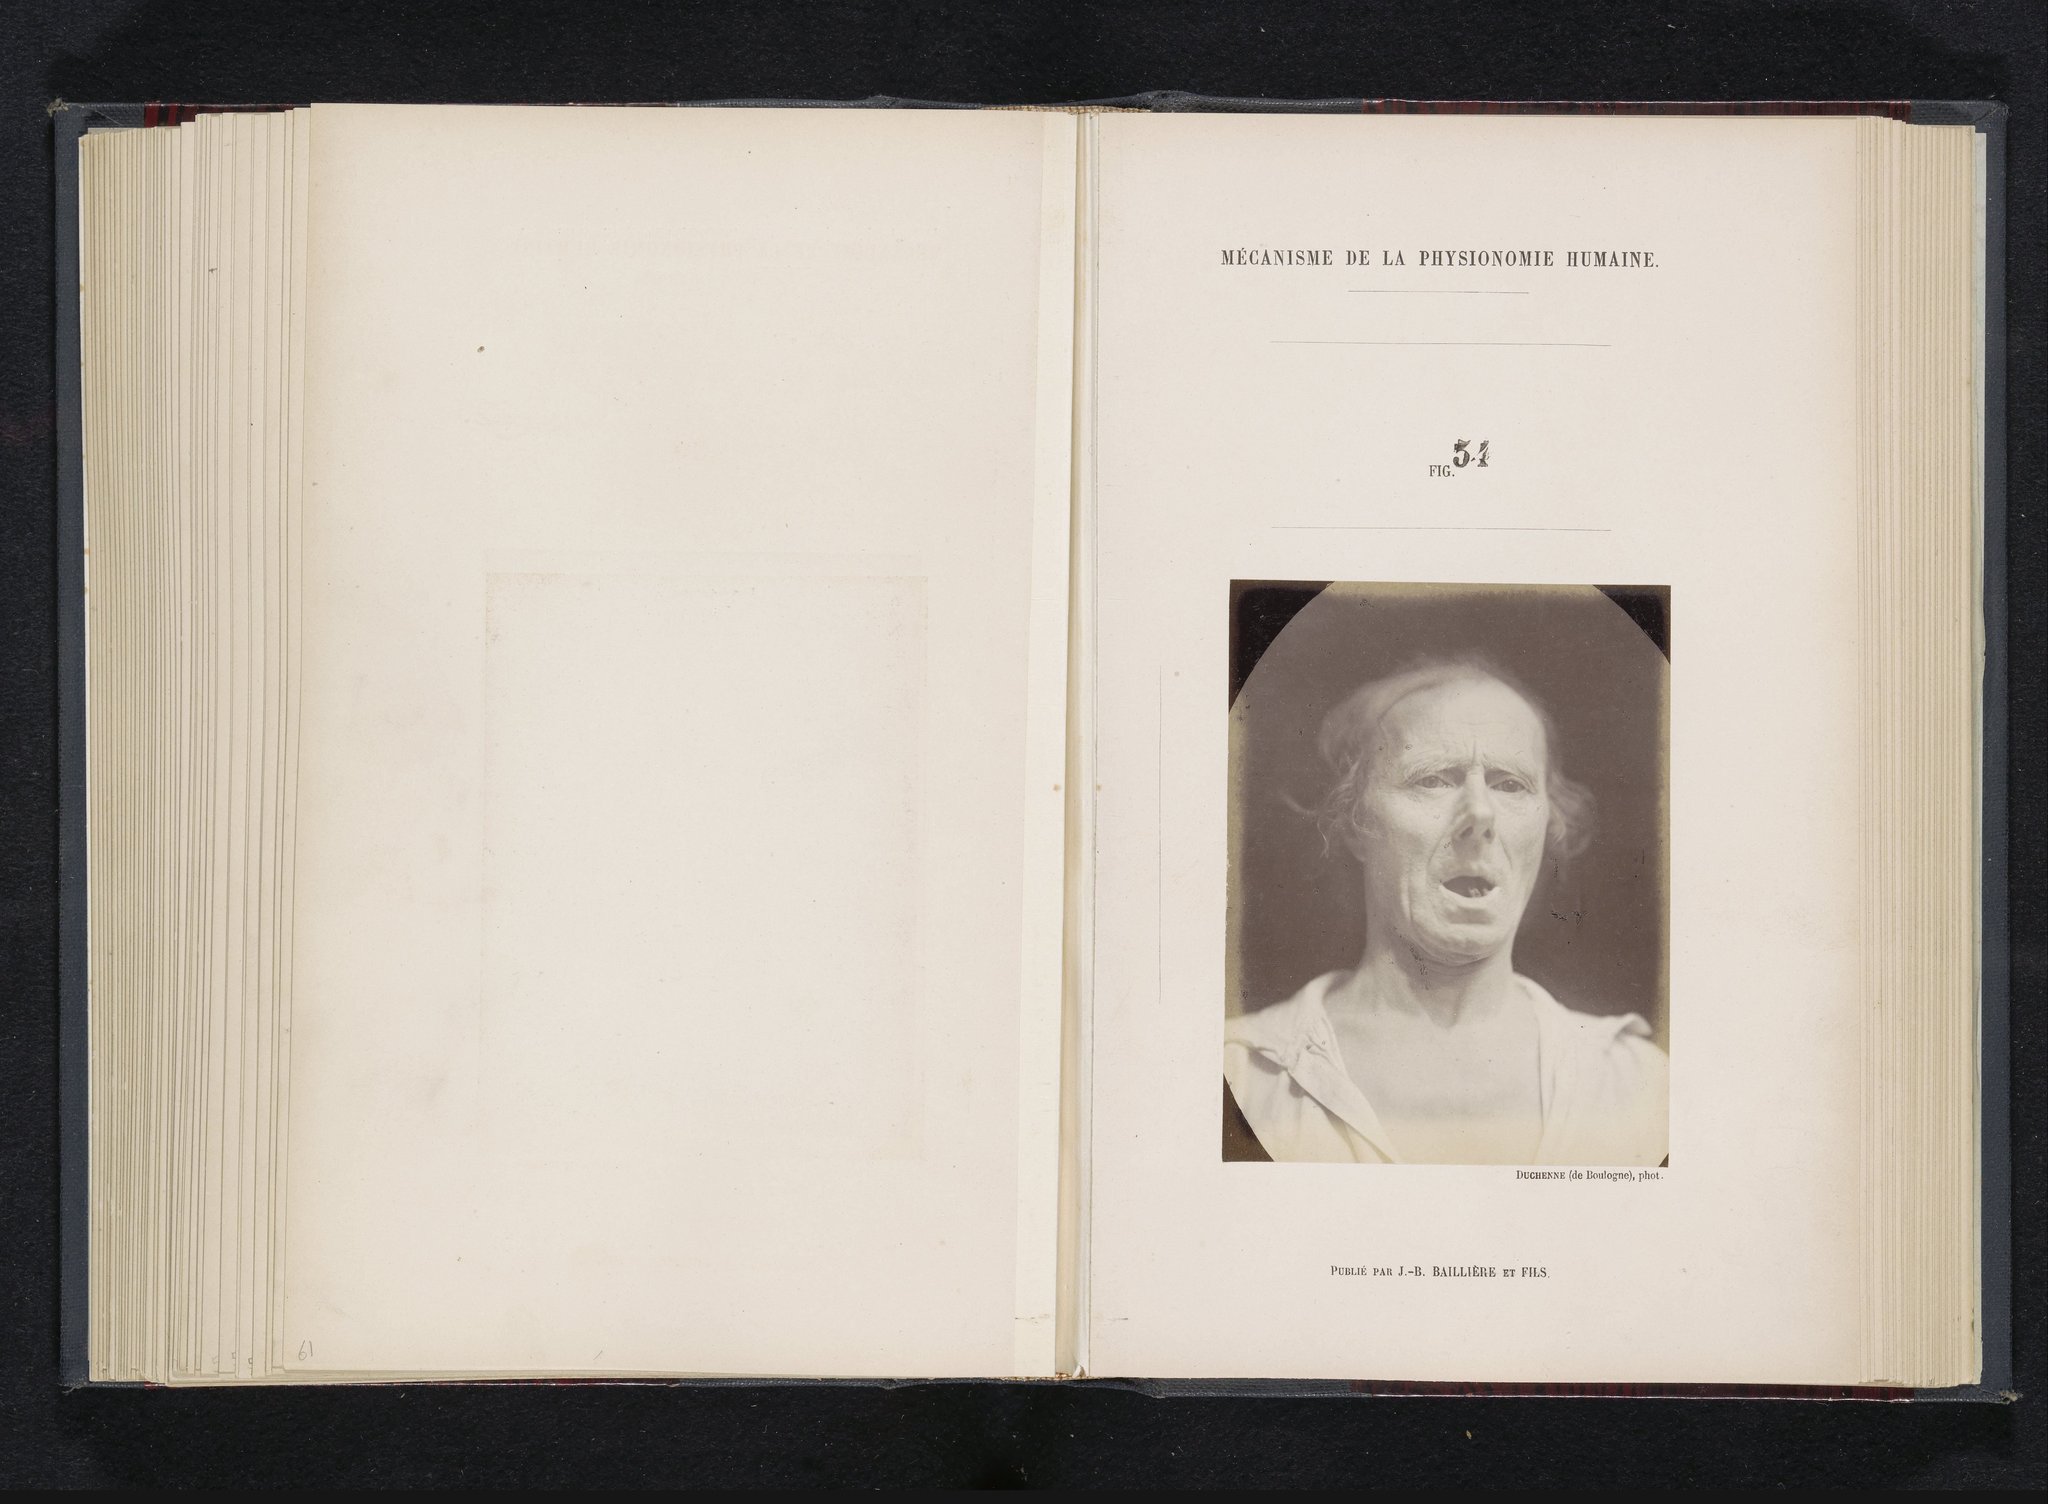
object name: page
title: Portret van een proefpersoon: 'un vieillard'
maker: guillaume benjamin amand duchenne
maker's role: fotograaf, medicus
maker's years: 1806-1875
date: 1860-1862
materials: paper, photographic support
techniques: albumen print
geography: france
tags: face, physiology and anatomy ~ nervous system, neurology, physiology and anatomy, old man, morphology of facial expression, physiognomy, experiment, test ~ science and technology, france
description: Ongenummerde pagina met foto 54 uit Mécanisme de la physionomie humaine ou analyse électro-physiologique de l'expression des passions (Atlas).